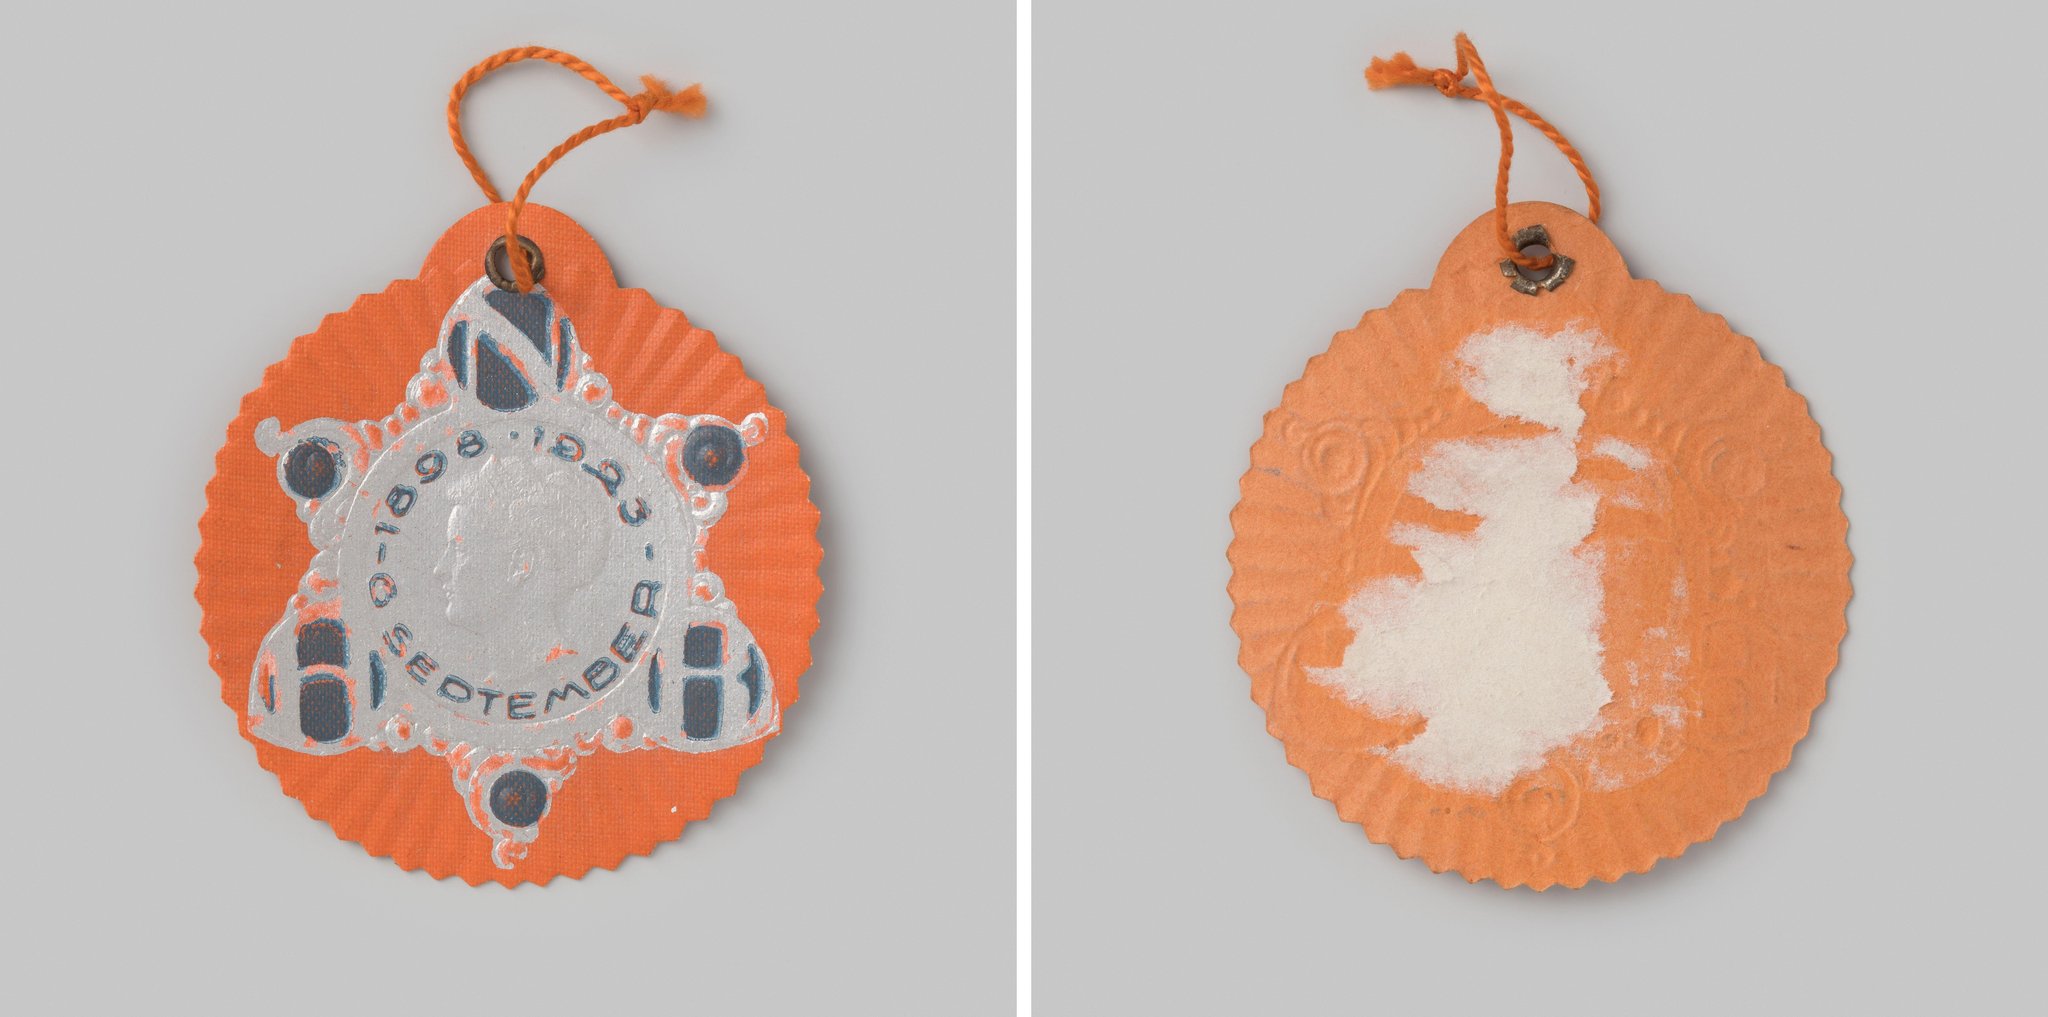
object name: insignia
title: Vijfentwintigjarig regeringsjubileum van Koningin Wilhelmina 1923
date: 1923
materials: cardboard, silk, metal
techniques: printing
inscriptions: circumscription: ‘1898 1923 / 6 SEPTEMBER’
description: Kartonnen draagteken in reliëfdruk, oranje met opdruk in grijsblauw en aluminium, portret van Wilhelmina met omschrift binnen een versiering waarin de letters NHB, aan oranje koordje.